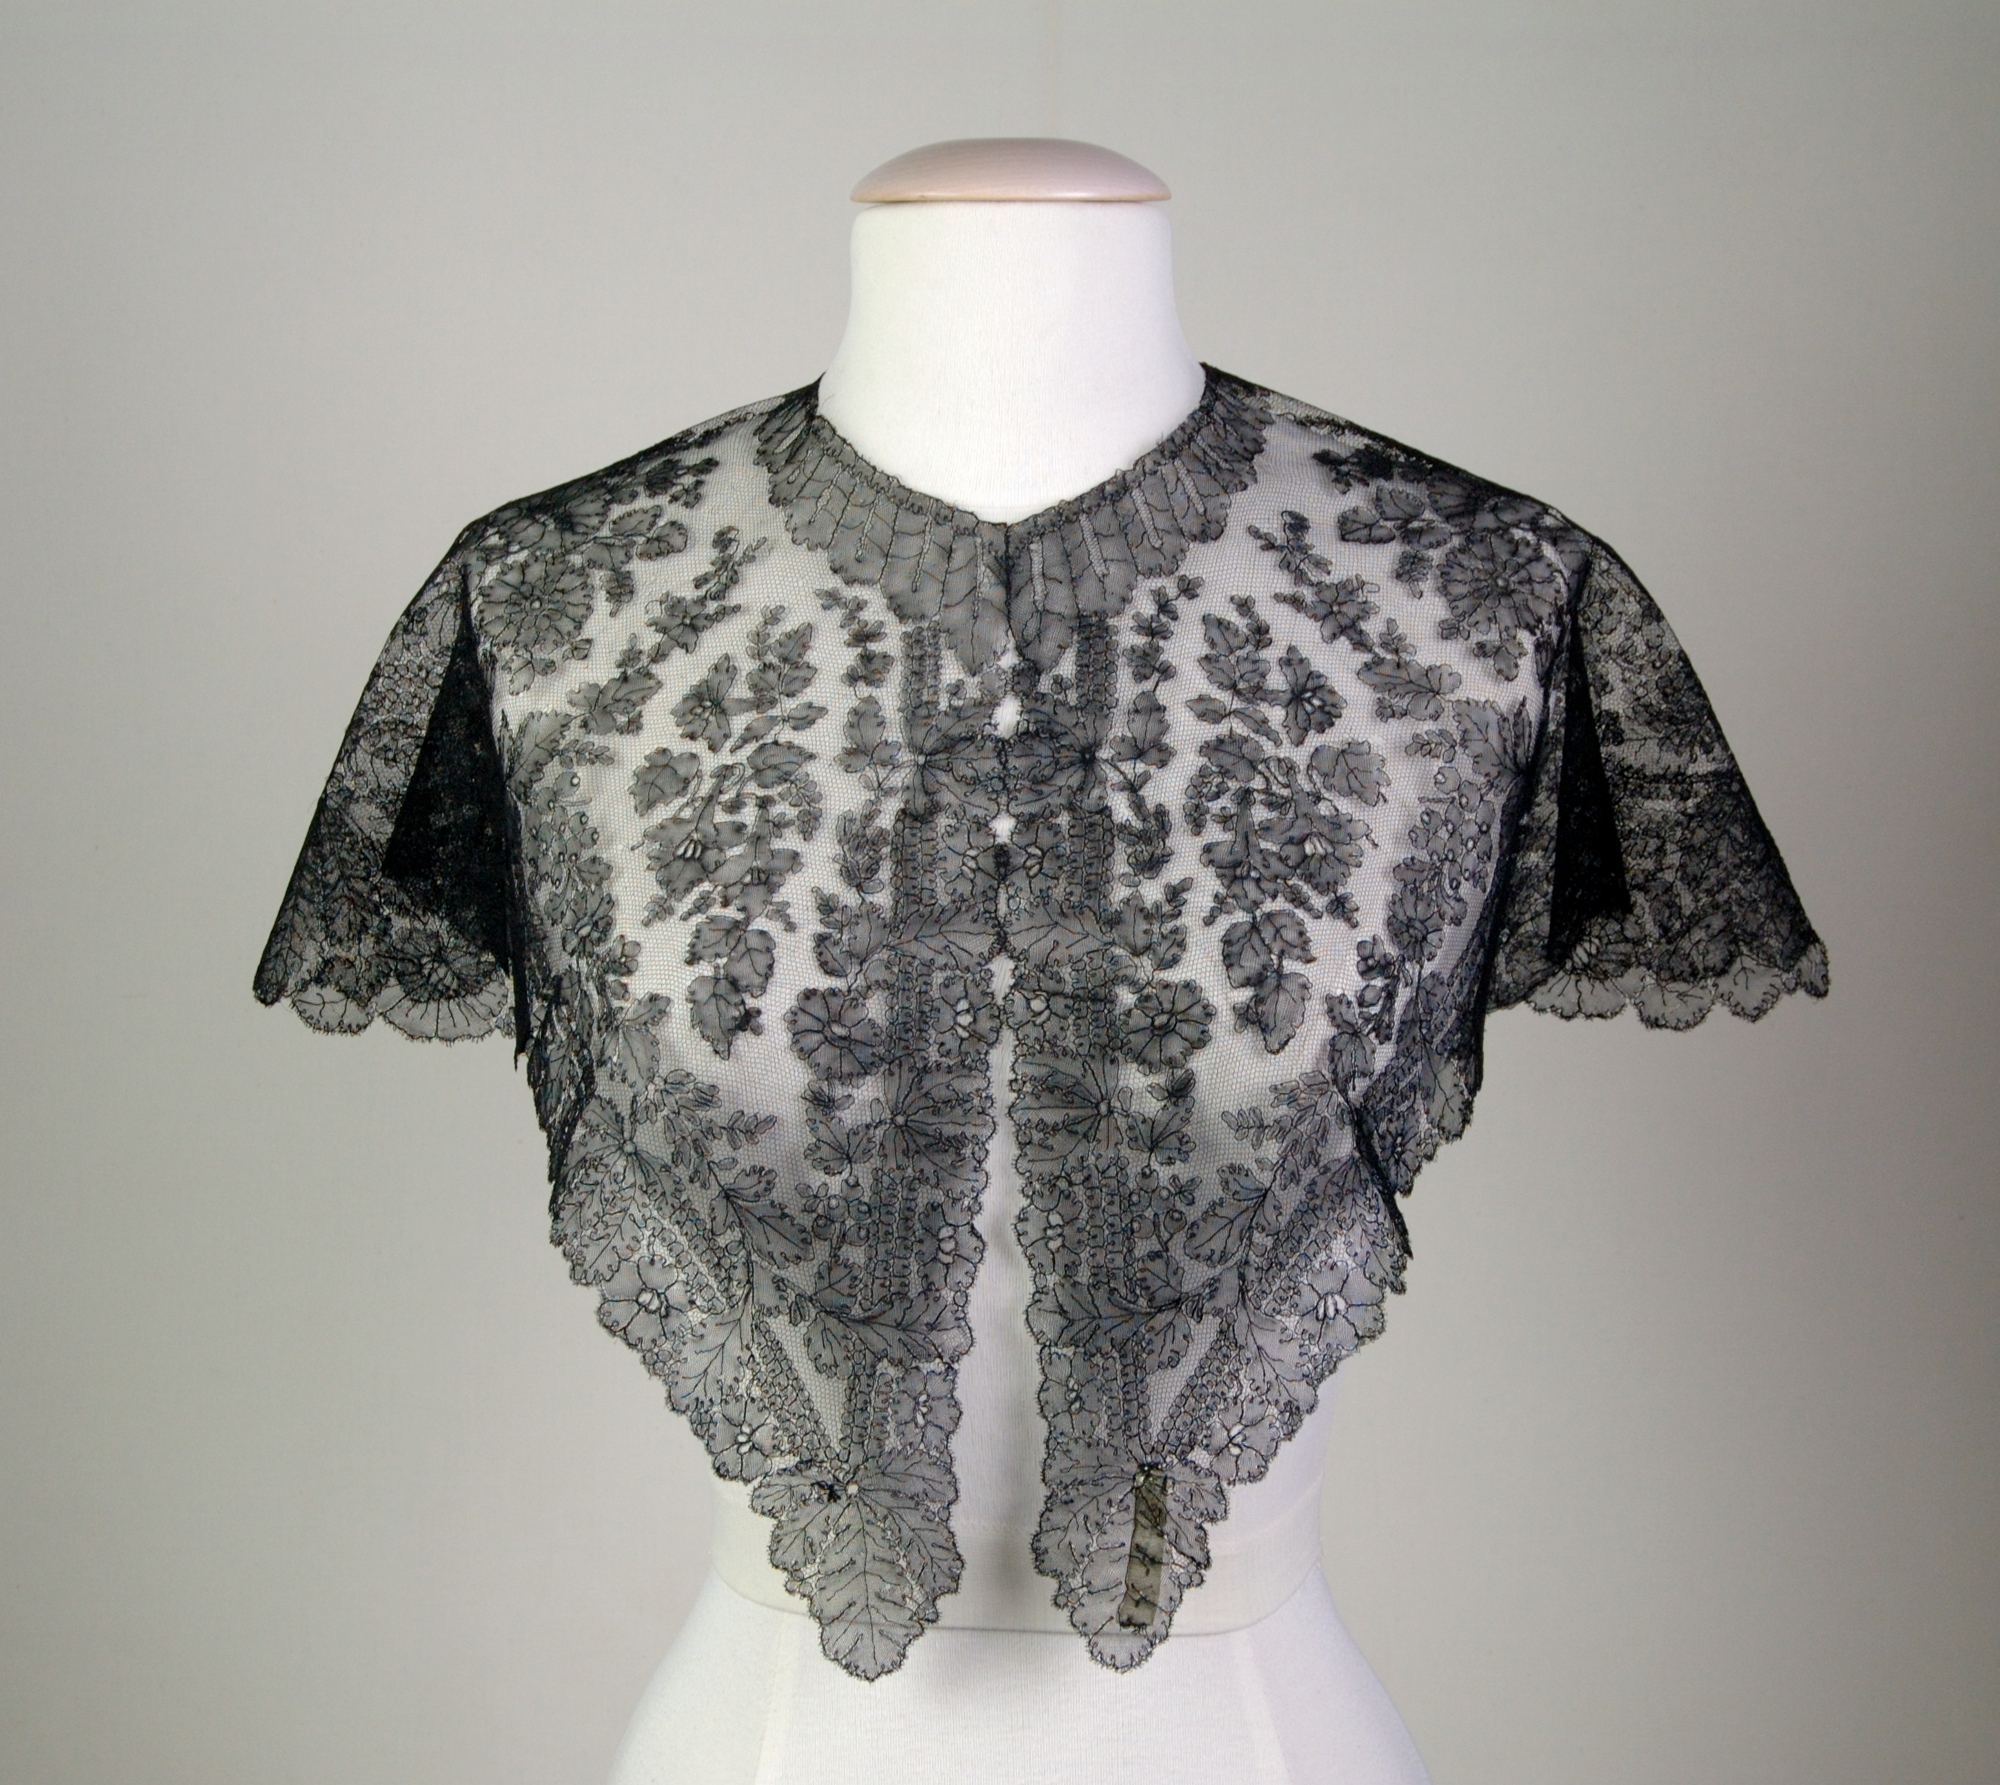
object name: pelerine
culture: french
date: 1860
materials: silk